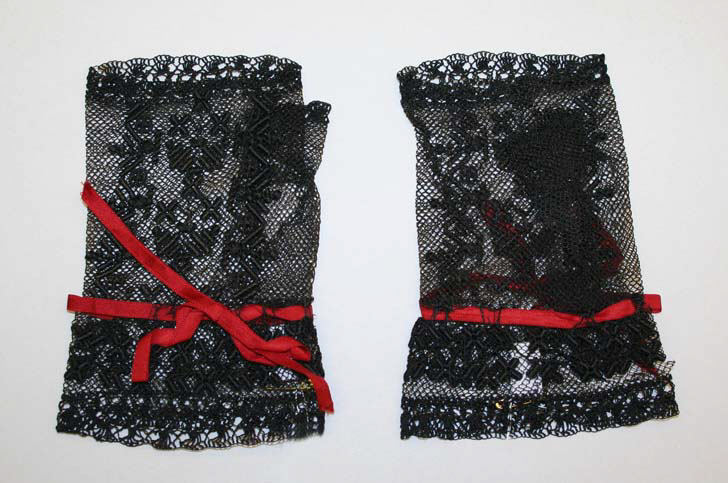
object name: mitt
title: Mitts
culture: american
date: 1860-1869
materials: silk